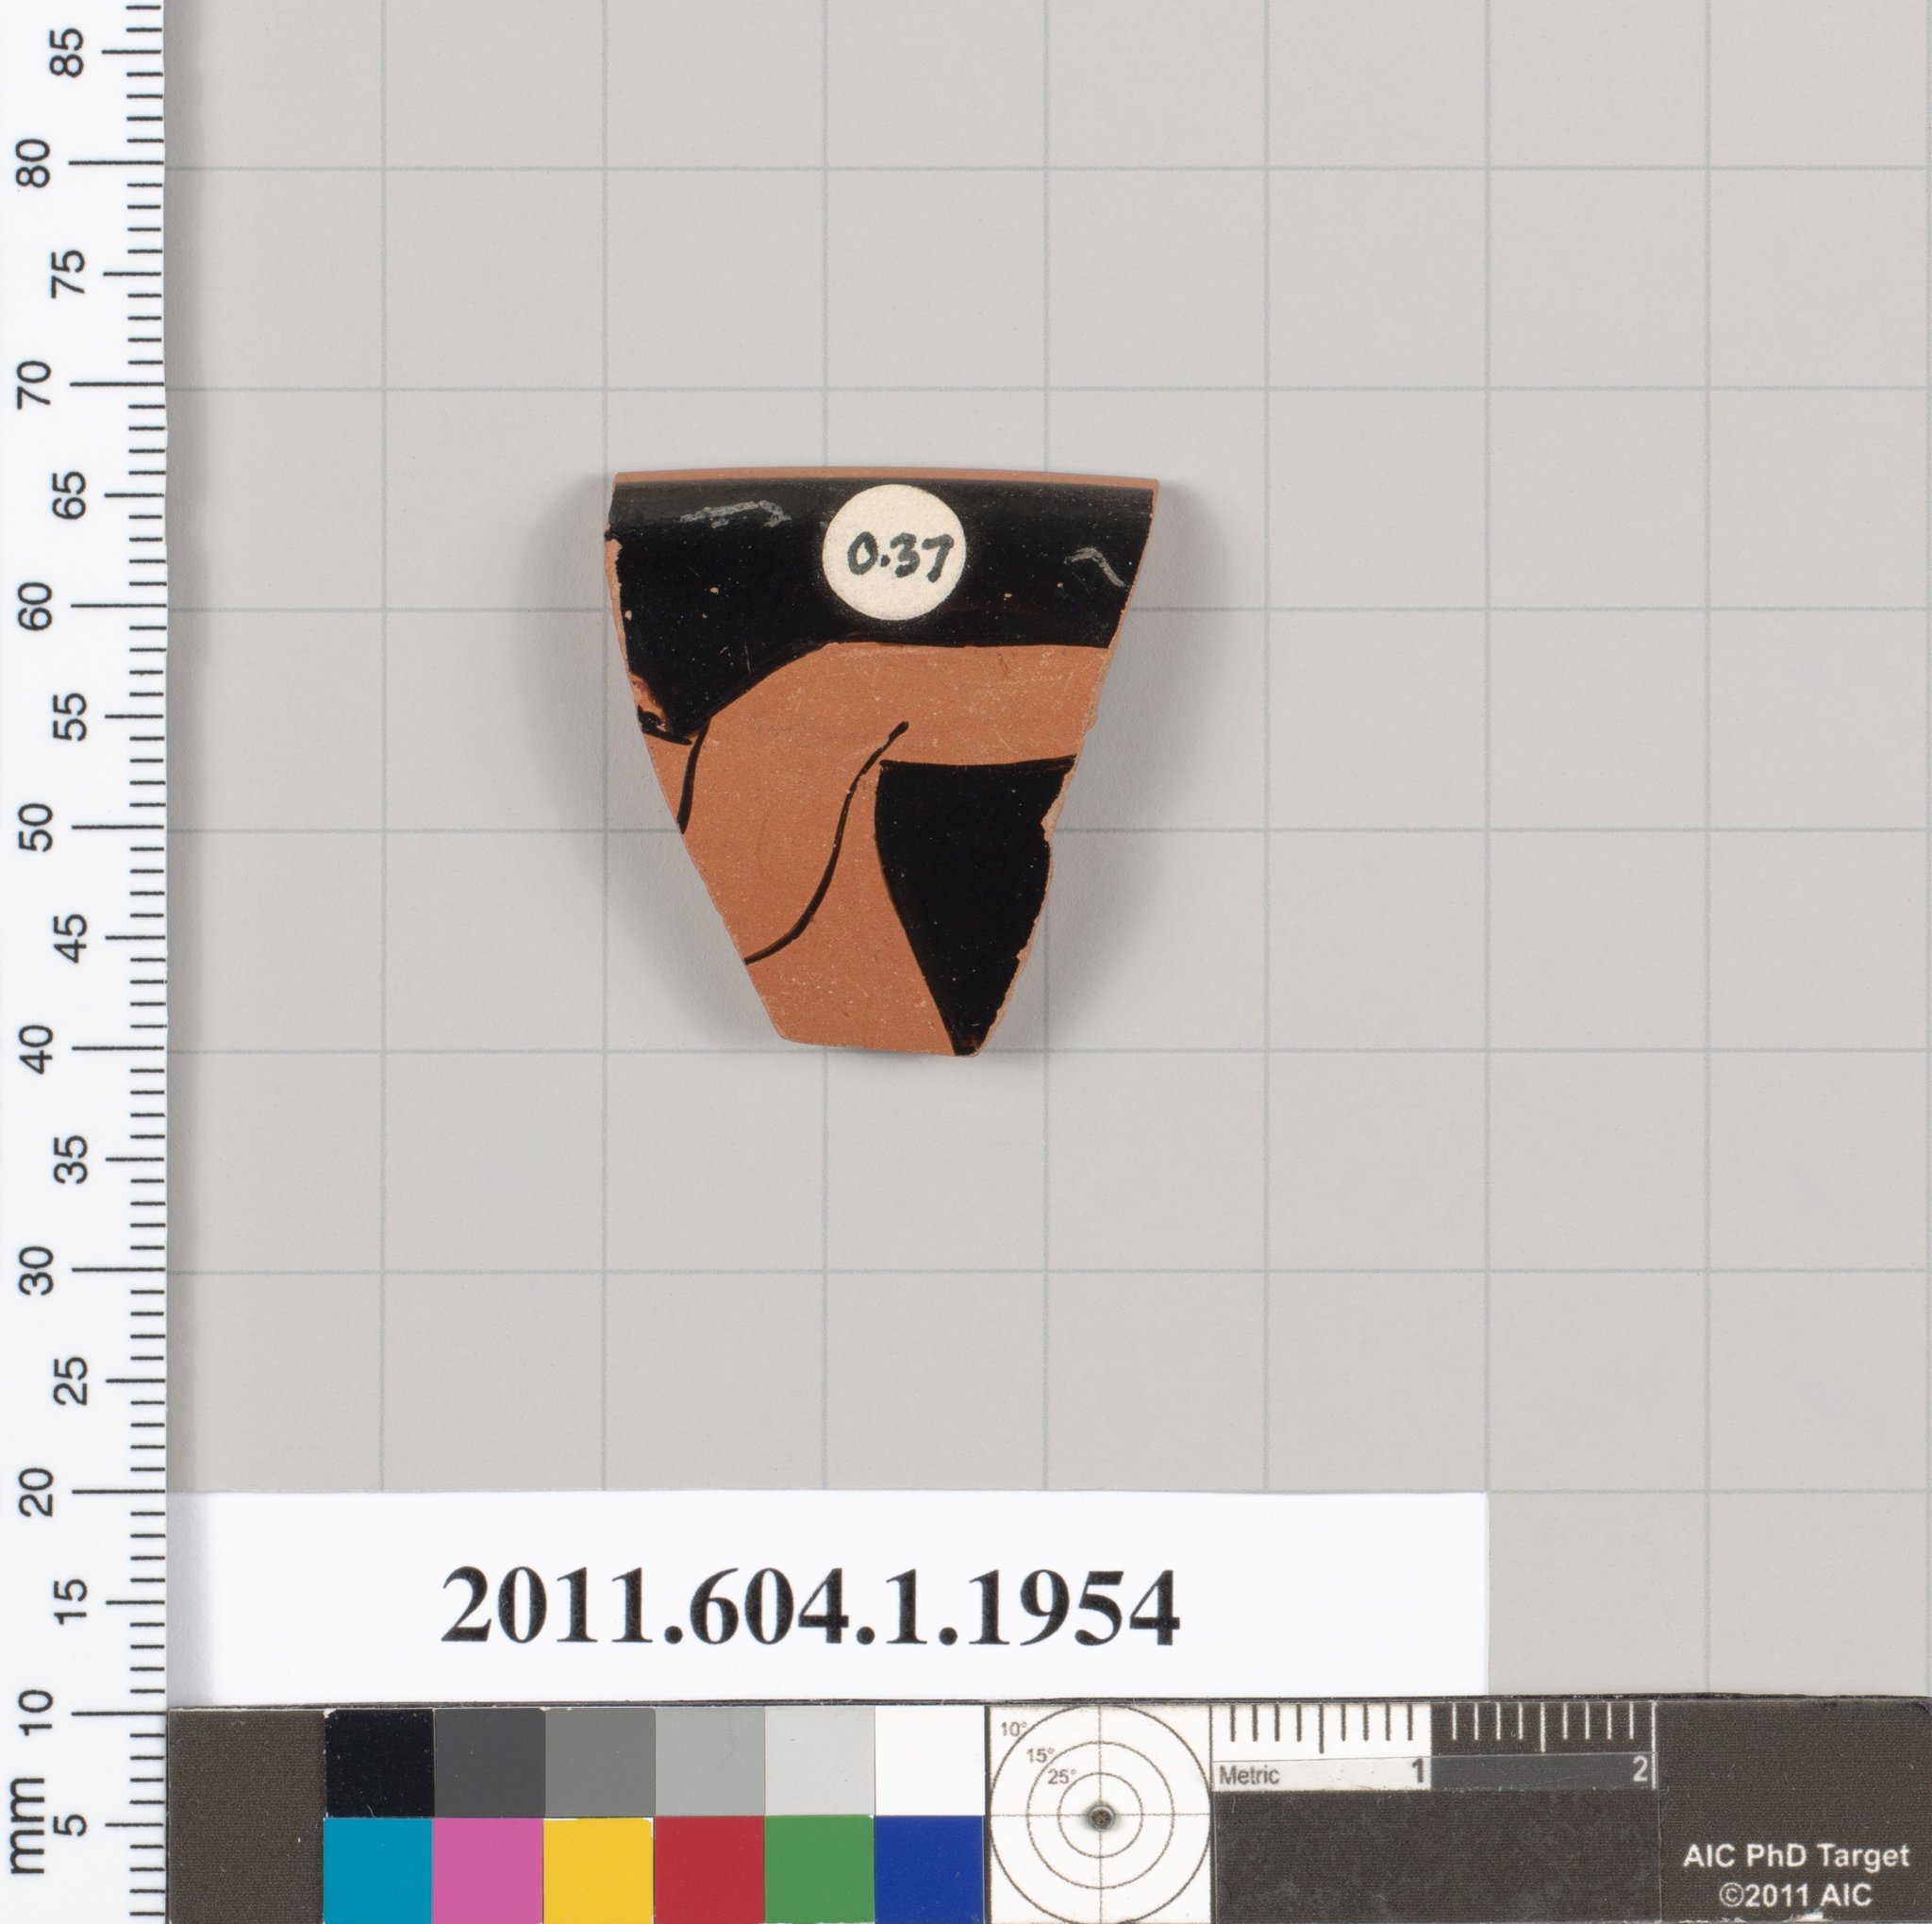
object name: kylix fragment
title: Terracotta rim fragment of a kylix (drinking cup)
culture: greek, attic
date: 490-480 BCE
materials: terracotta